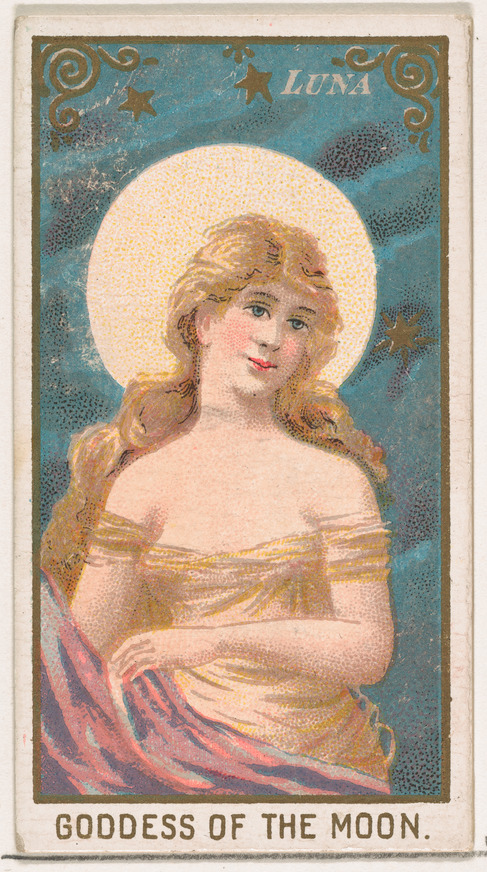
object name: print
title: Luna, Goddess of the Moon, from the Goddesses of the Greeks and Romans series (N188) issued by Wm. S. Kimball & Co.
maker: william s. kimball & company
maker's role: publisher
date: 1889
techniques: color lithograph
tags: goddess